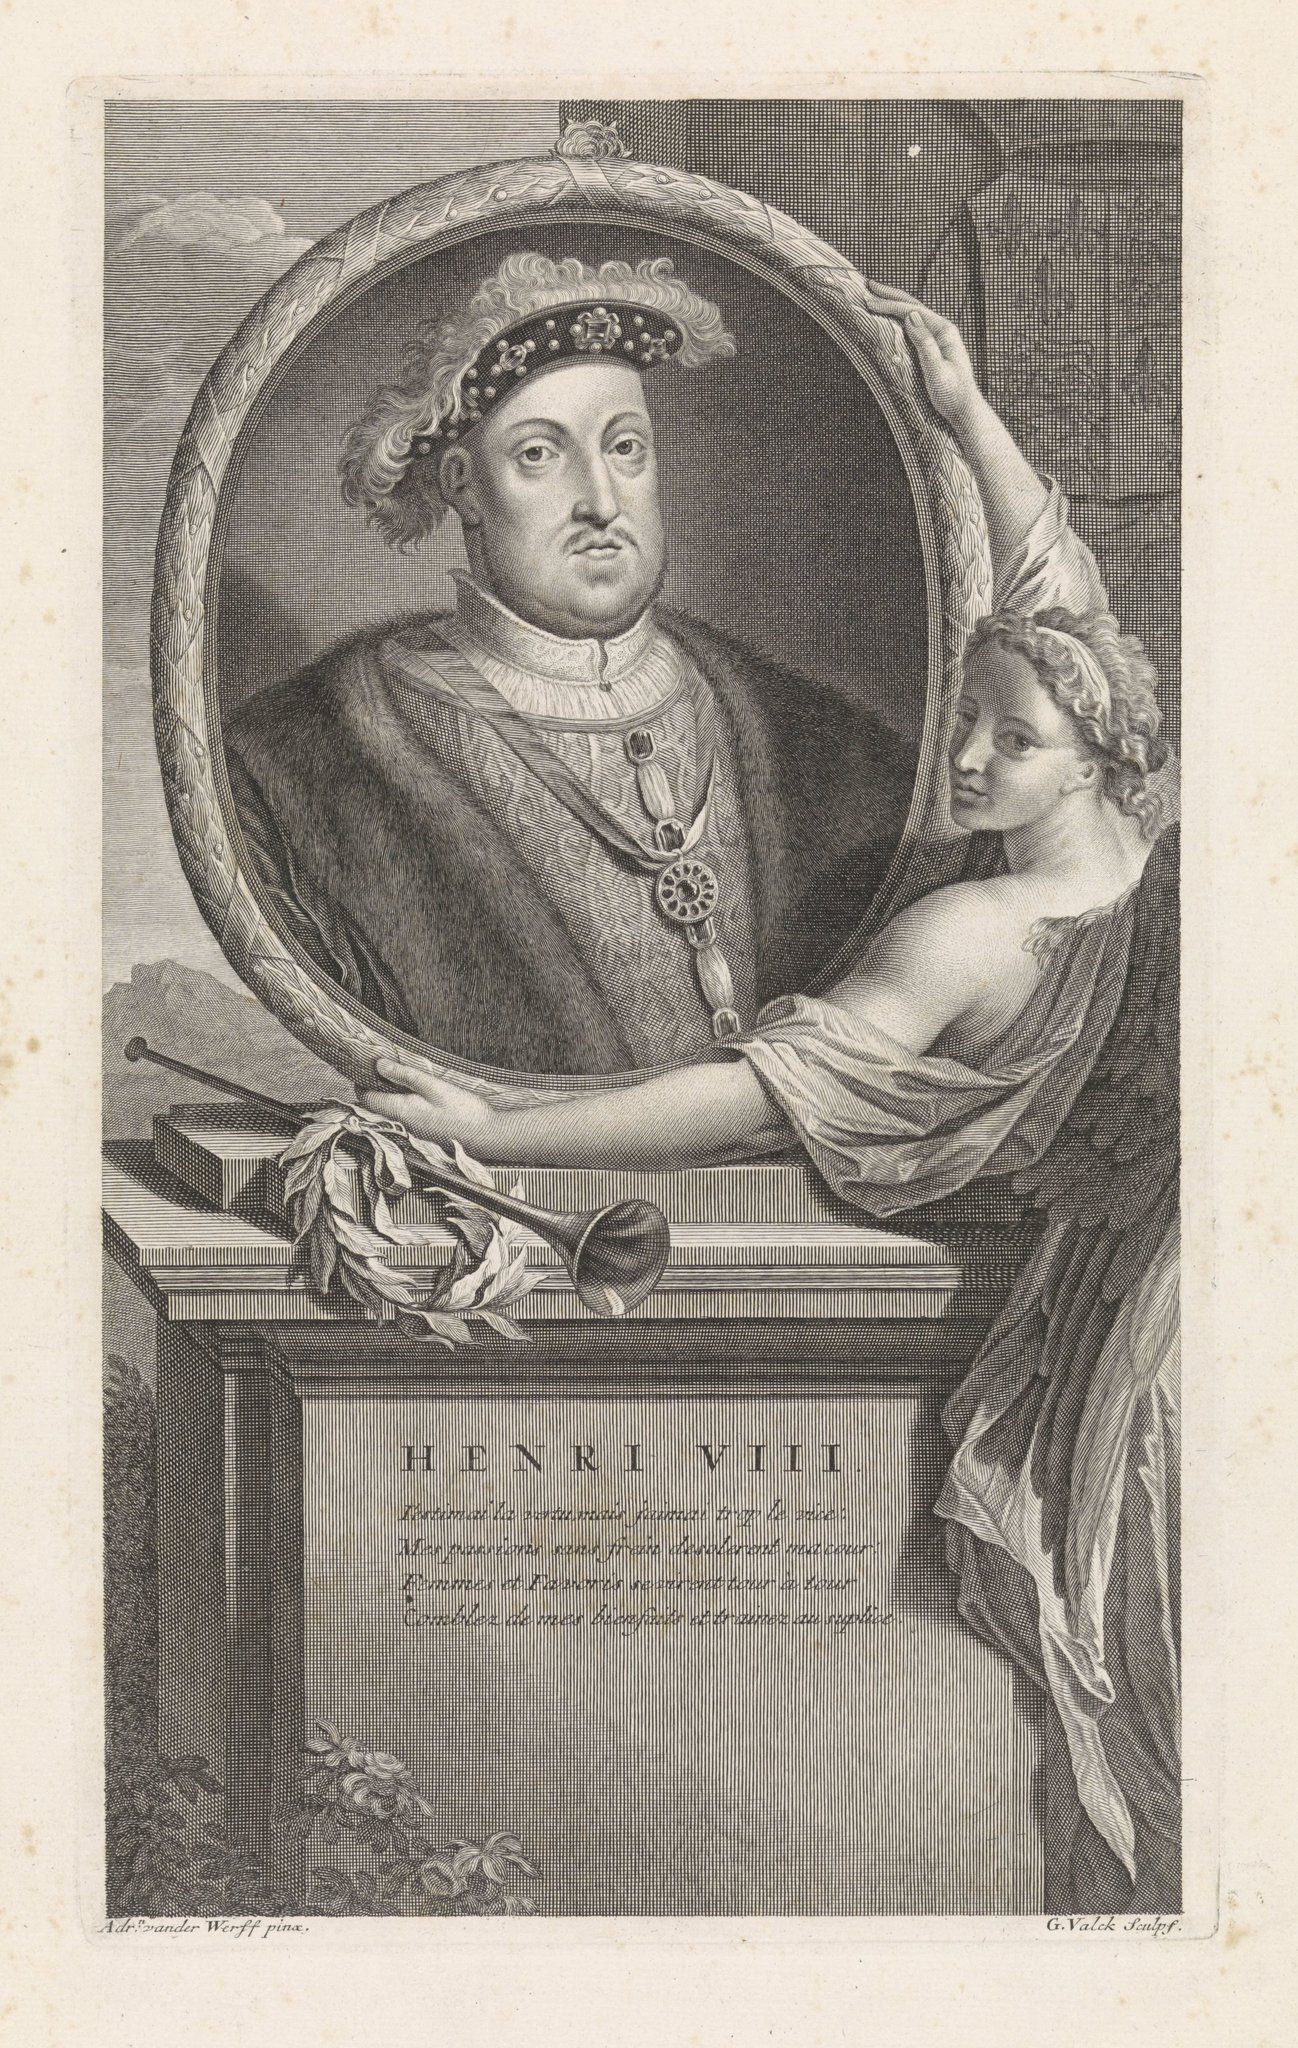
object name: print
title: Zeven portretten van historische figuren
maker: adriaen van der werff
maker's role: draughtsman, painter, print maker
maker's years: 1659-1722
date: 1697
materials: paper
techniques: engraving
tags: fame; 'fama', 'fama buona', 'fama chiara' (ripa)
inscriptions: collector's mark: Lugt 2228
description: Portret van Hendrik VIII, koning van Engeland en Ierland, dat wordt vastgehouden door Faam; als staande engel met naast haar op de sokkel bazuin en lauwerkrans. Prent uit een serie van zeven portretten van historische figuren.